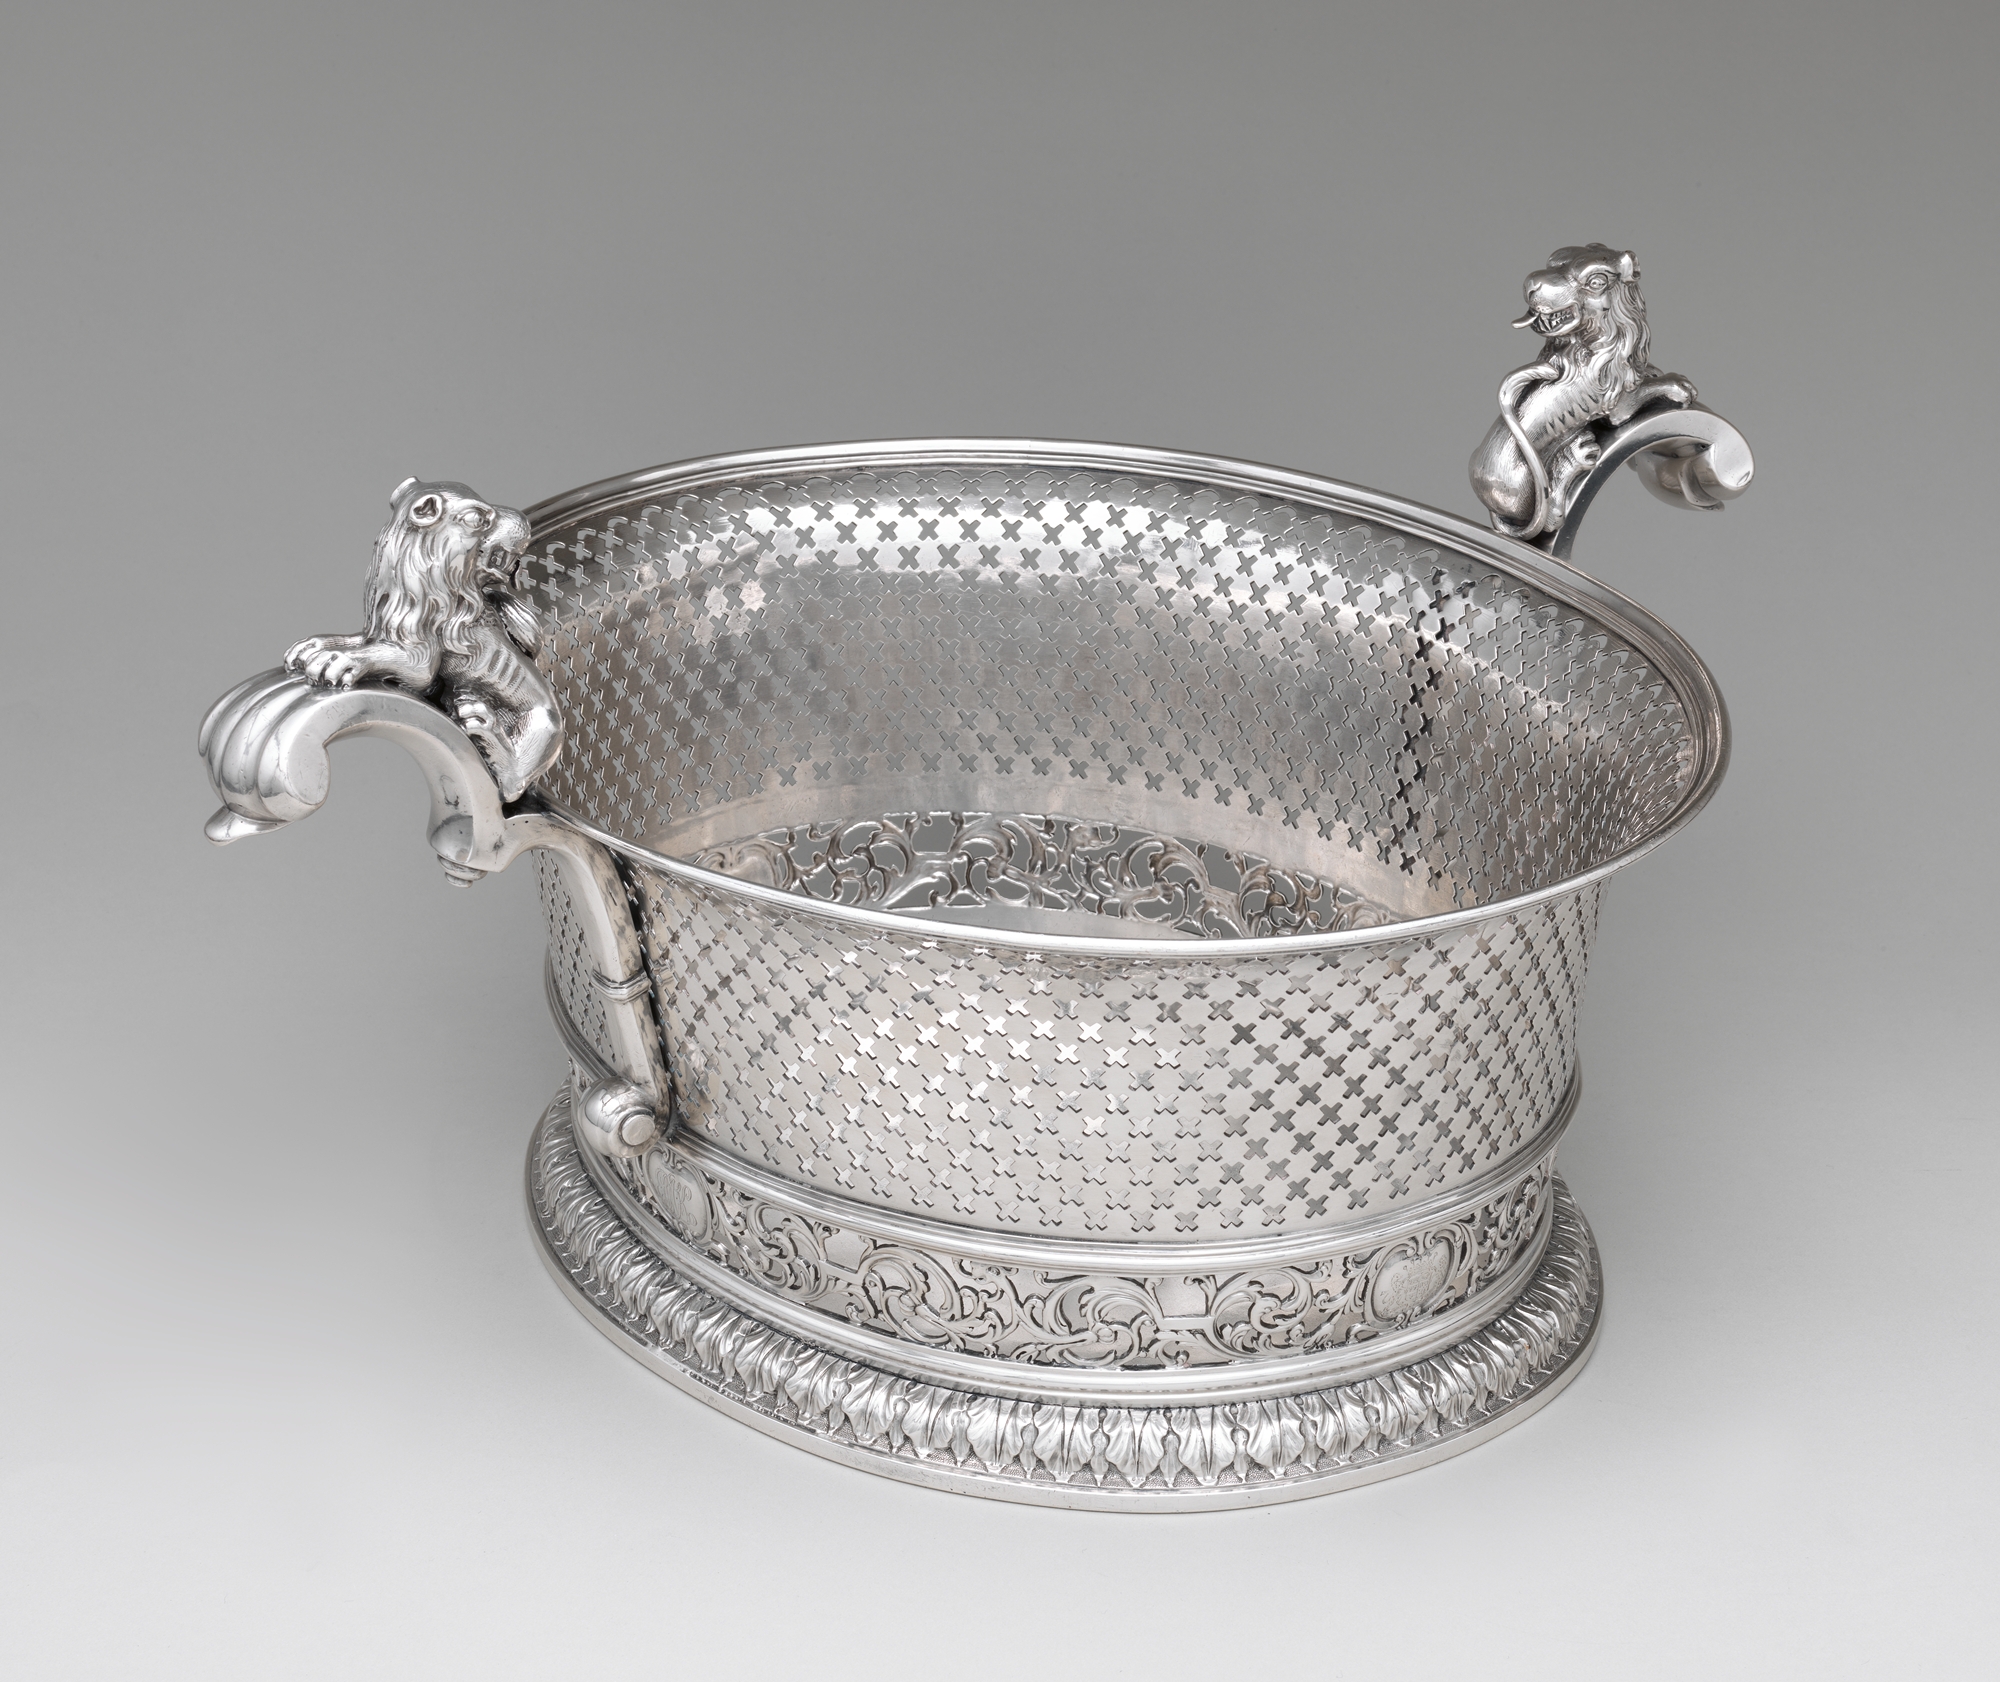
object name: basket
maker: john edwards ii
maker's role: maker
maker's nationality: british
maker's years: 1723-1753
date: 1731-1732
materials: silver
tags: lions